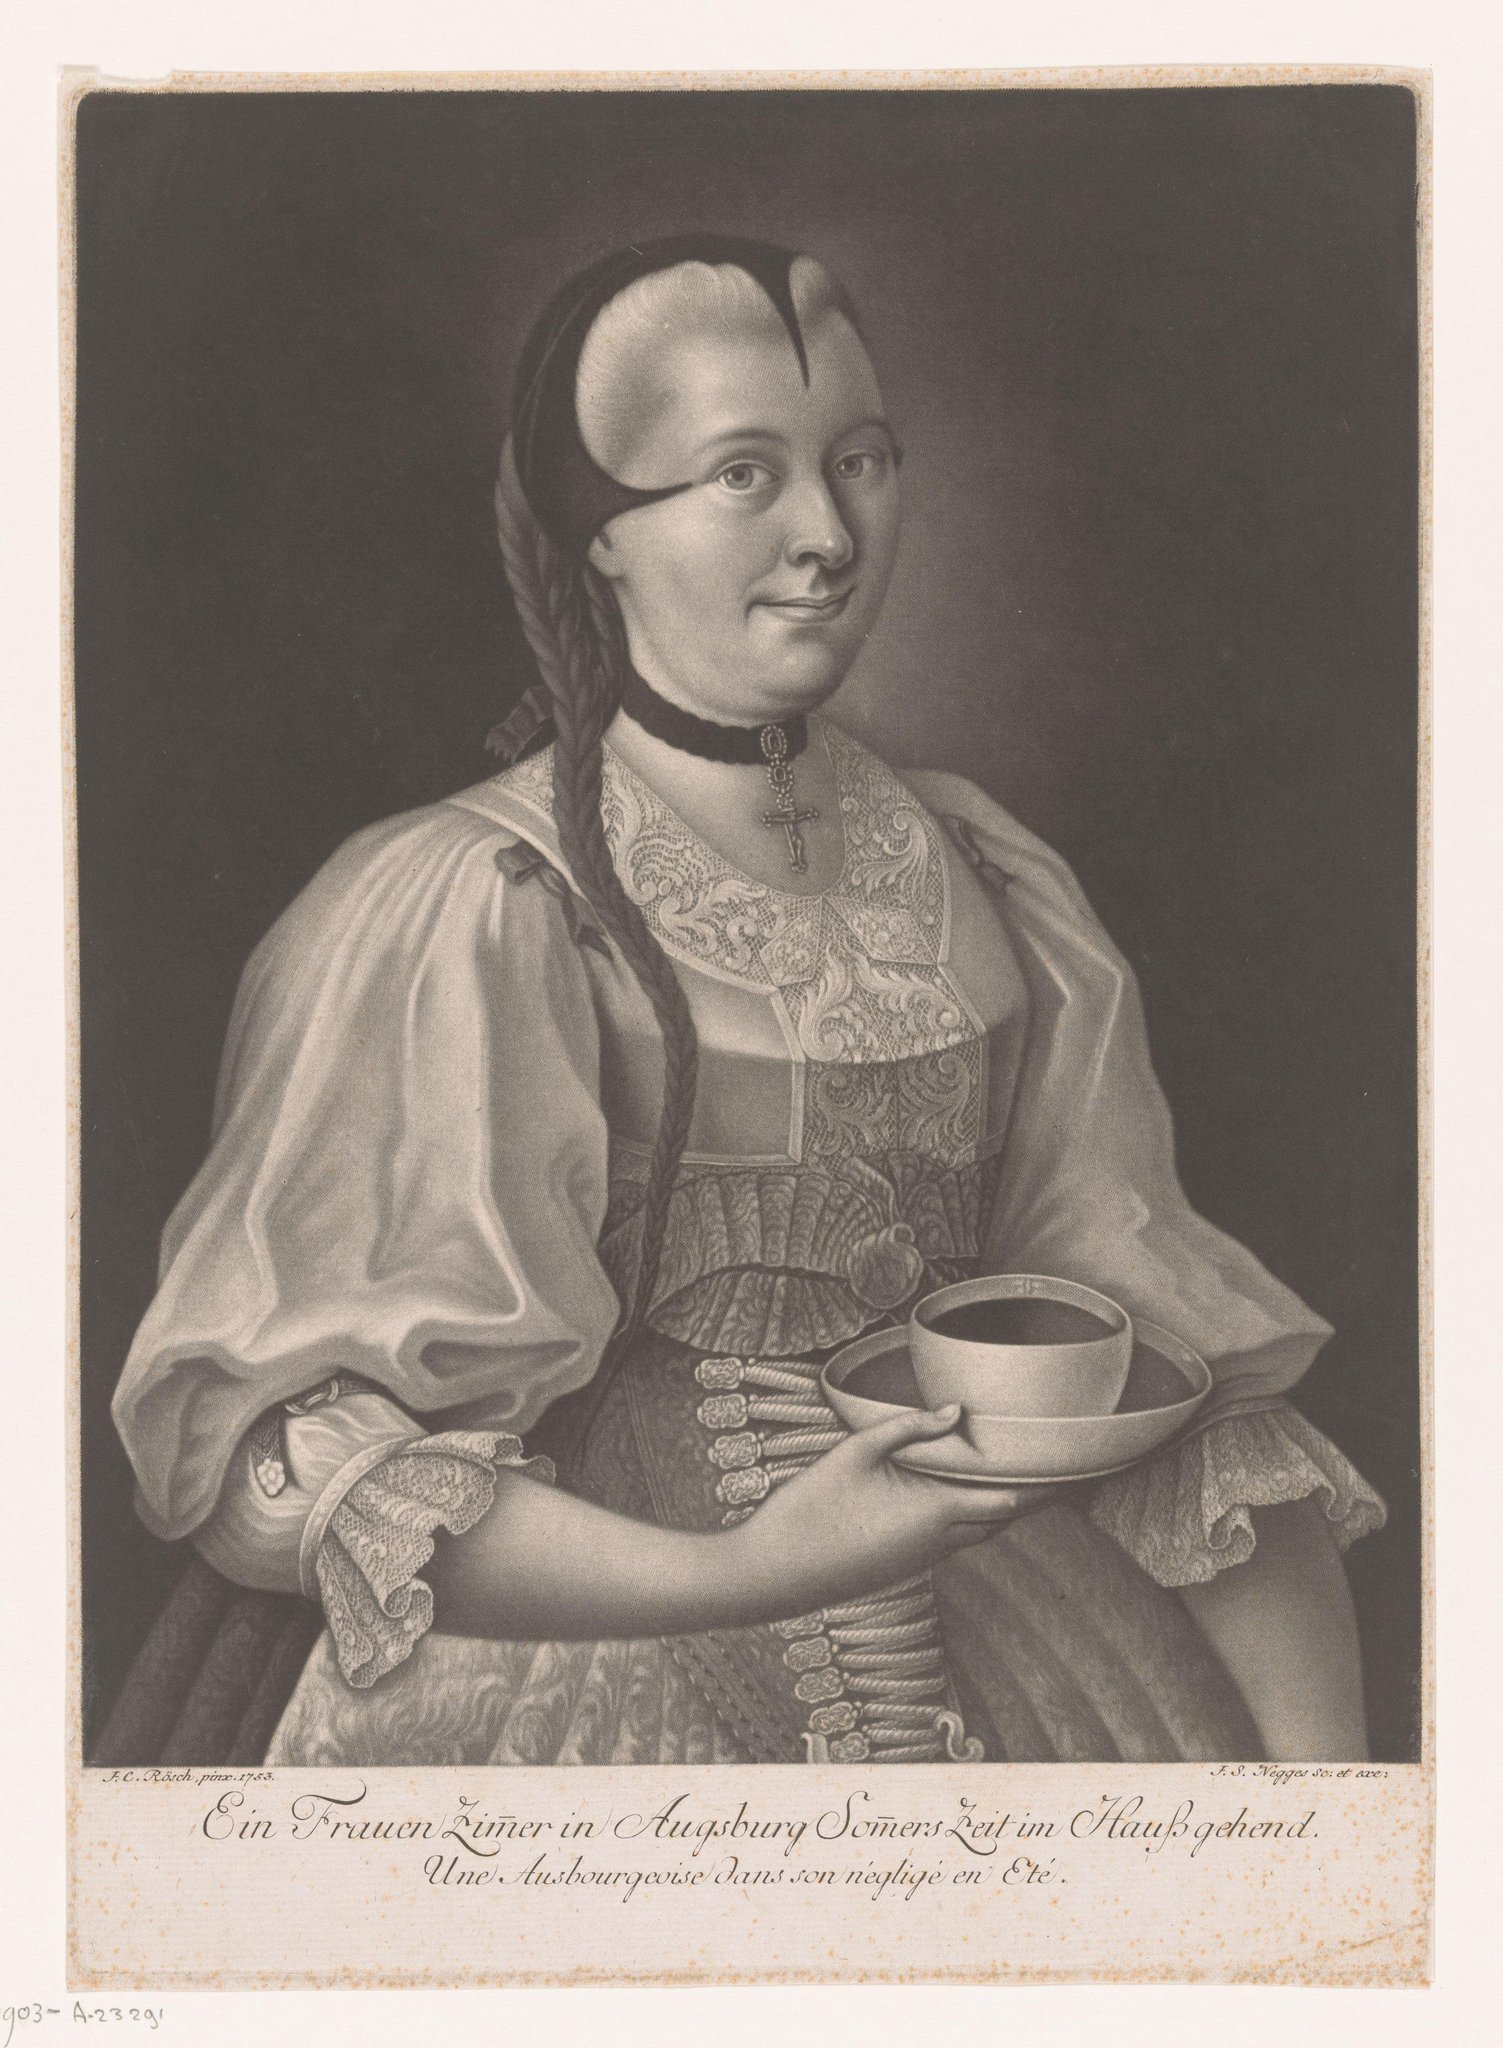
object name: print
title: Ein Frauenzimmer in Augsburg Sommer Zeit im Haus gehend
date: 1753-1792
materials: paper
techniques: mezzotint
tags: historical persons - bb - woman, folk costume, regional costume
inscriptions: collector's mark: Lugt 2228